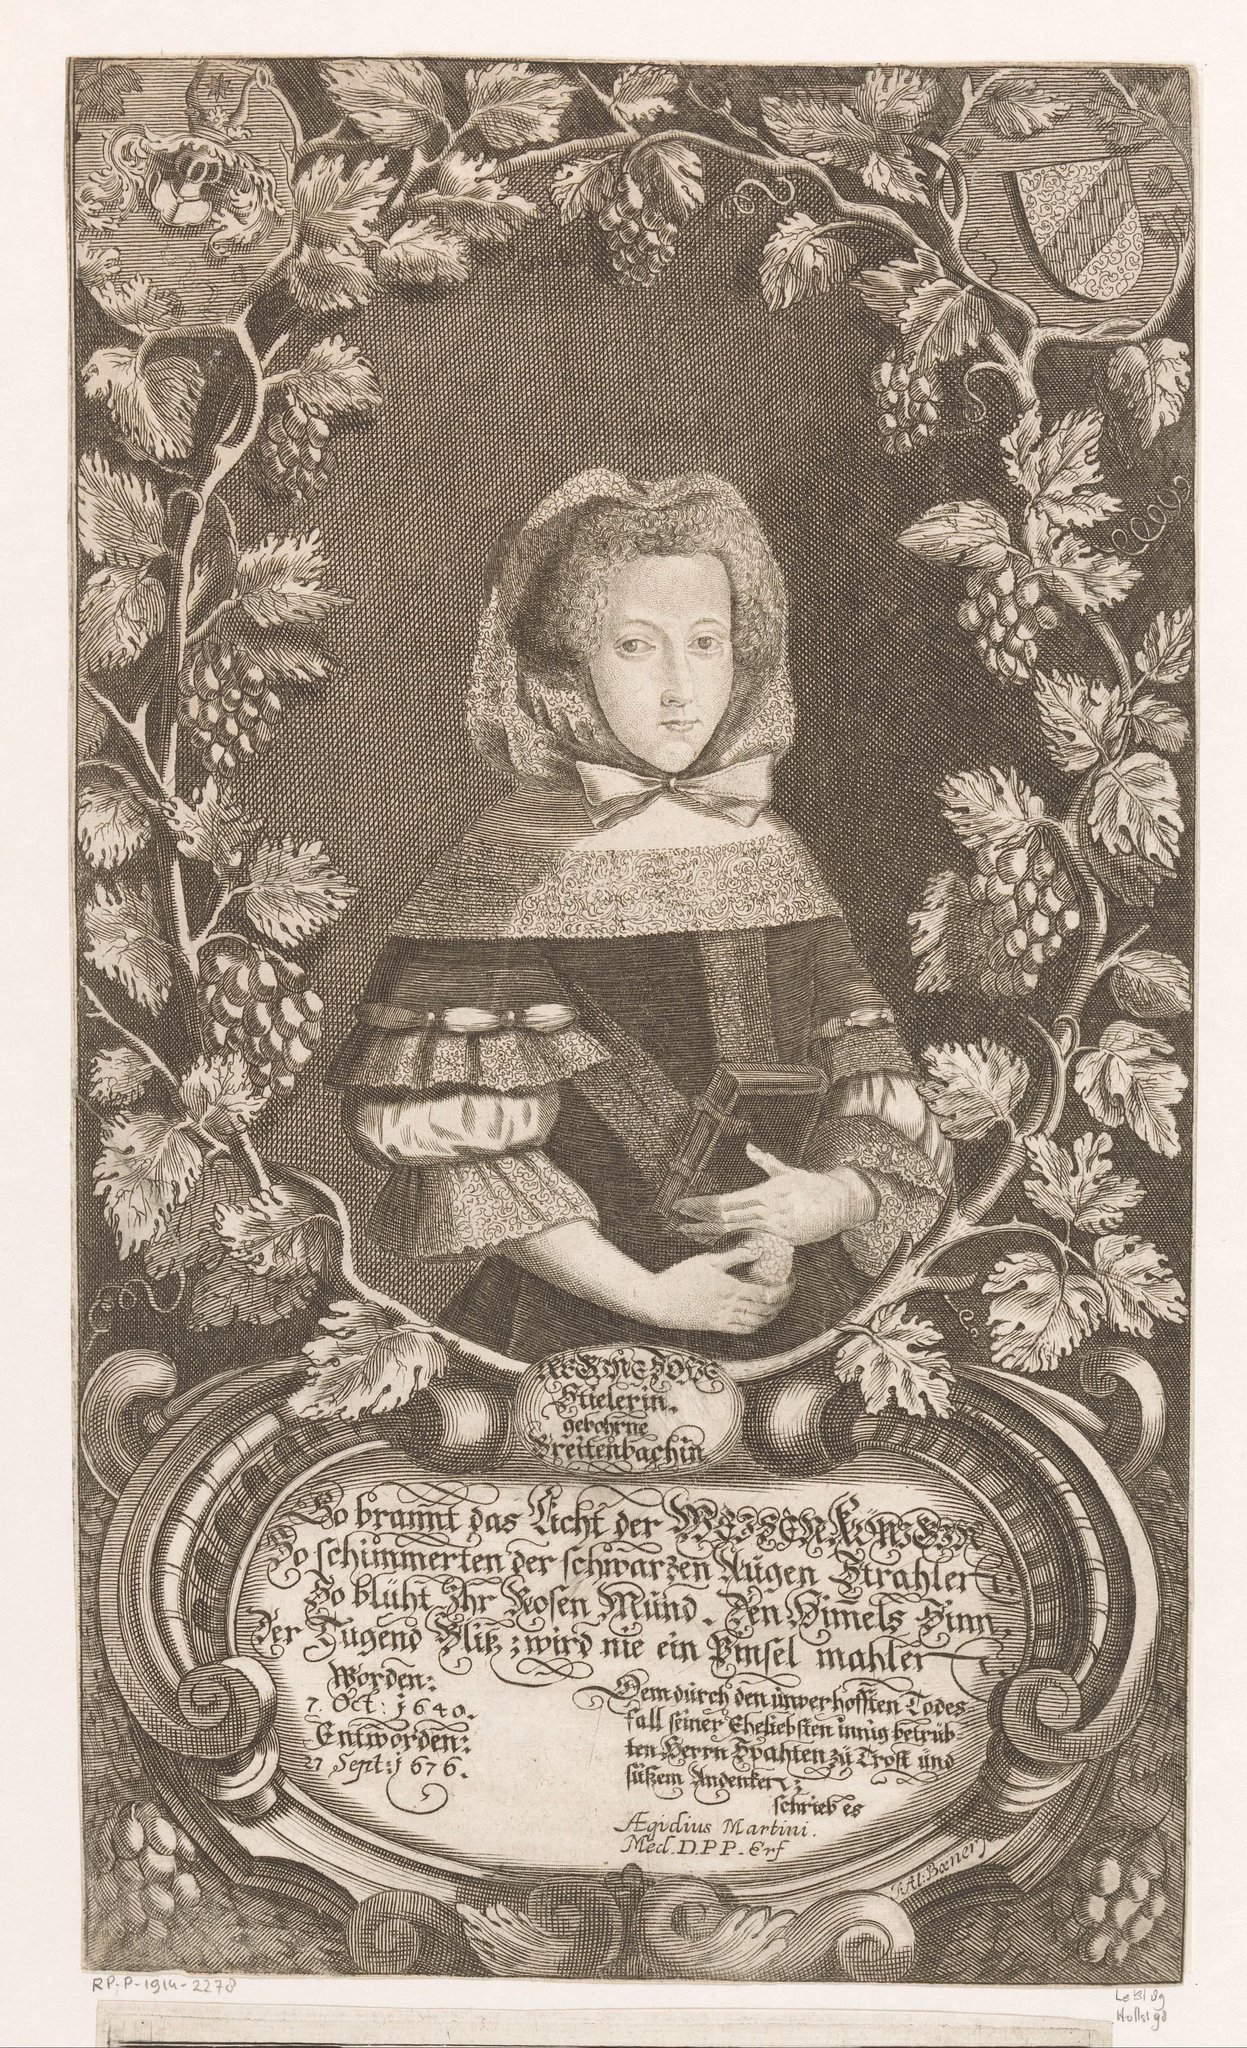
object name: print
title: Portret van Regine Sophie Stieler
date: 1676-1720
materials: paper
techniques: engraving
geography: erfurt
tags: regine sophie stieler, fruits and vegetables ~ ornament, historical persons - bb - woman, book, armorial bearing, heraldry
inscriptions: collector's mark: Lugt 2228